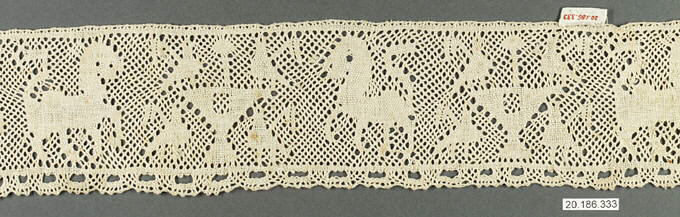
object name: edging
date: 1701-1800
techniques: lace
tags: animals